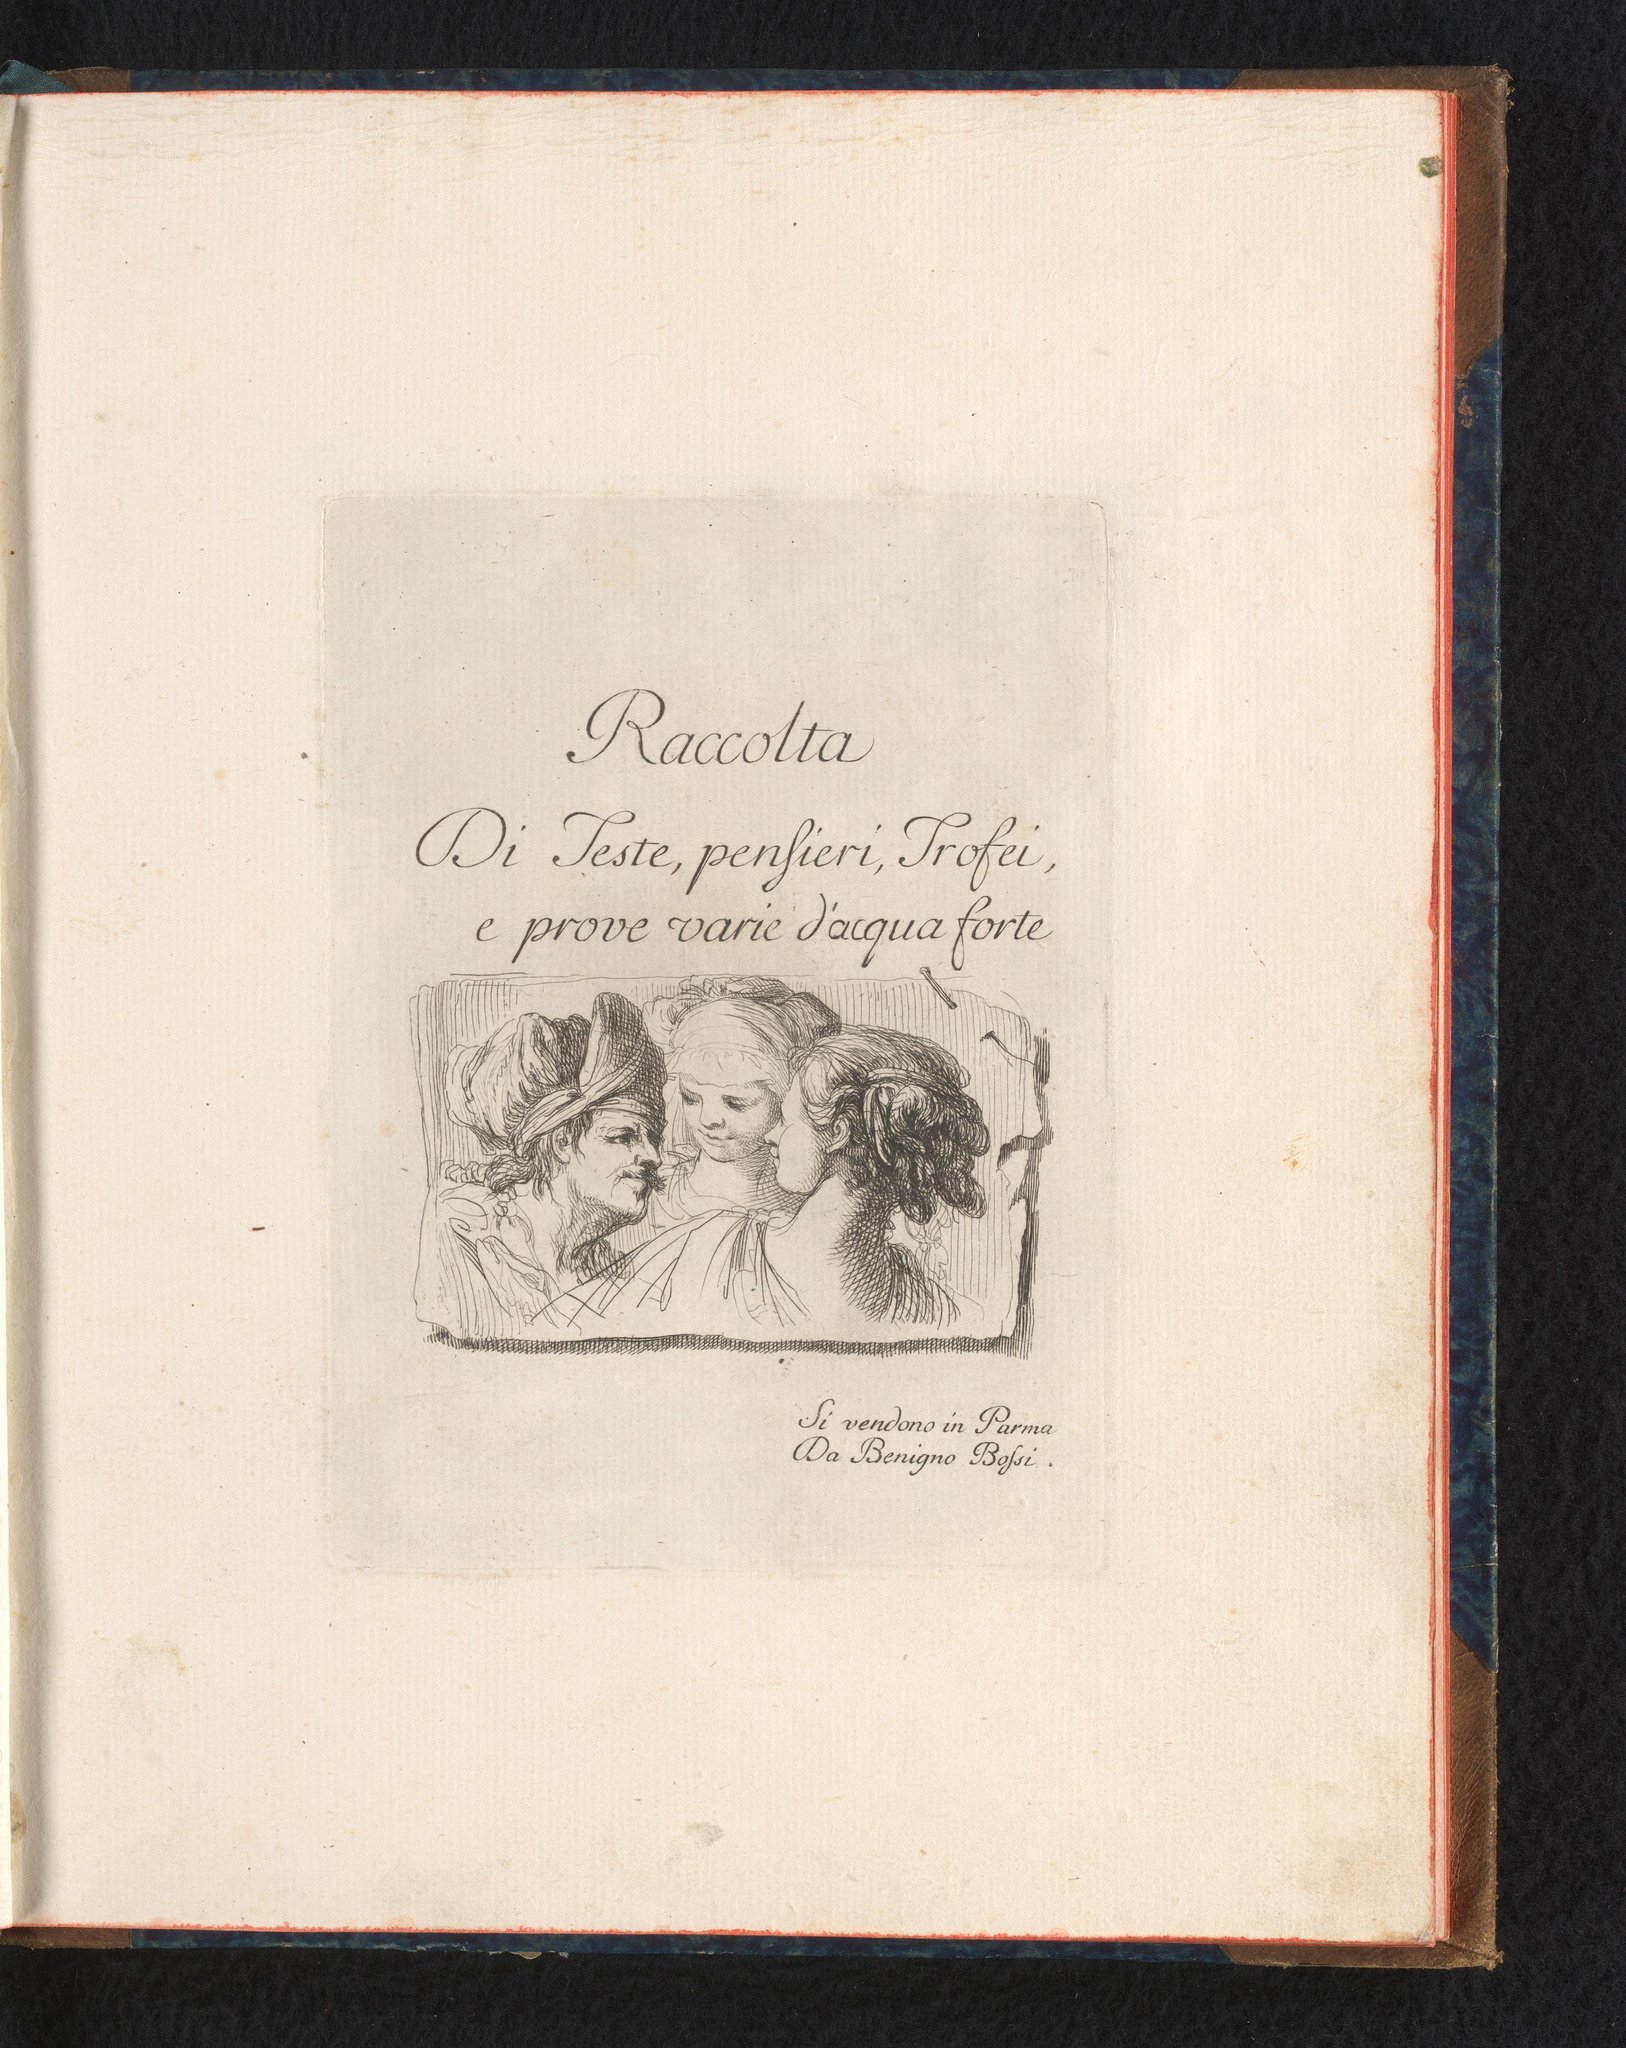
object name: print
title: Titelprent met drie hoofden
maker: benigno bossi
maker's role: print maker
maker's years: 1727-1792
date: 1754-1772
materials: paper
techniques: etching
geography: parma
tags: head (human), title-page